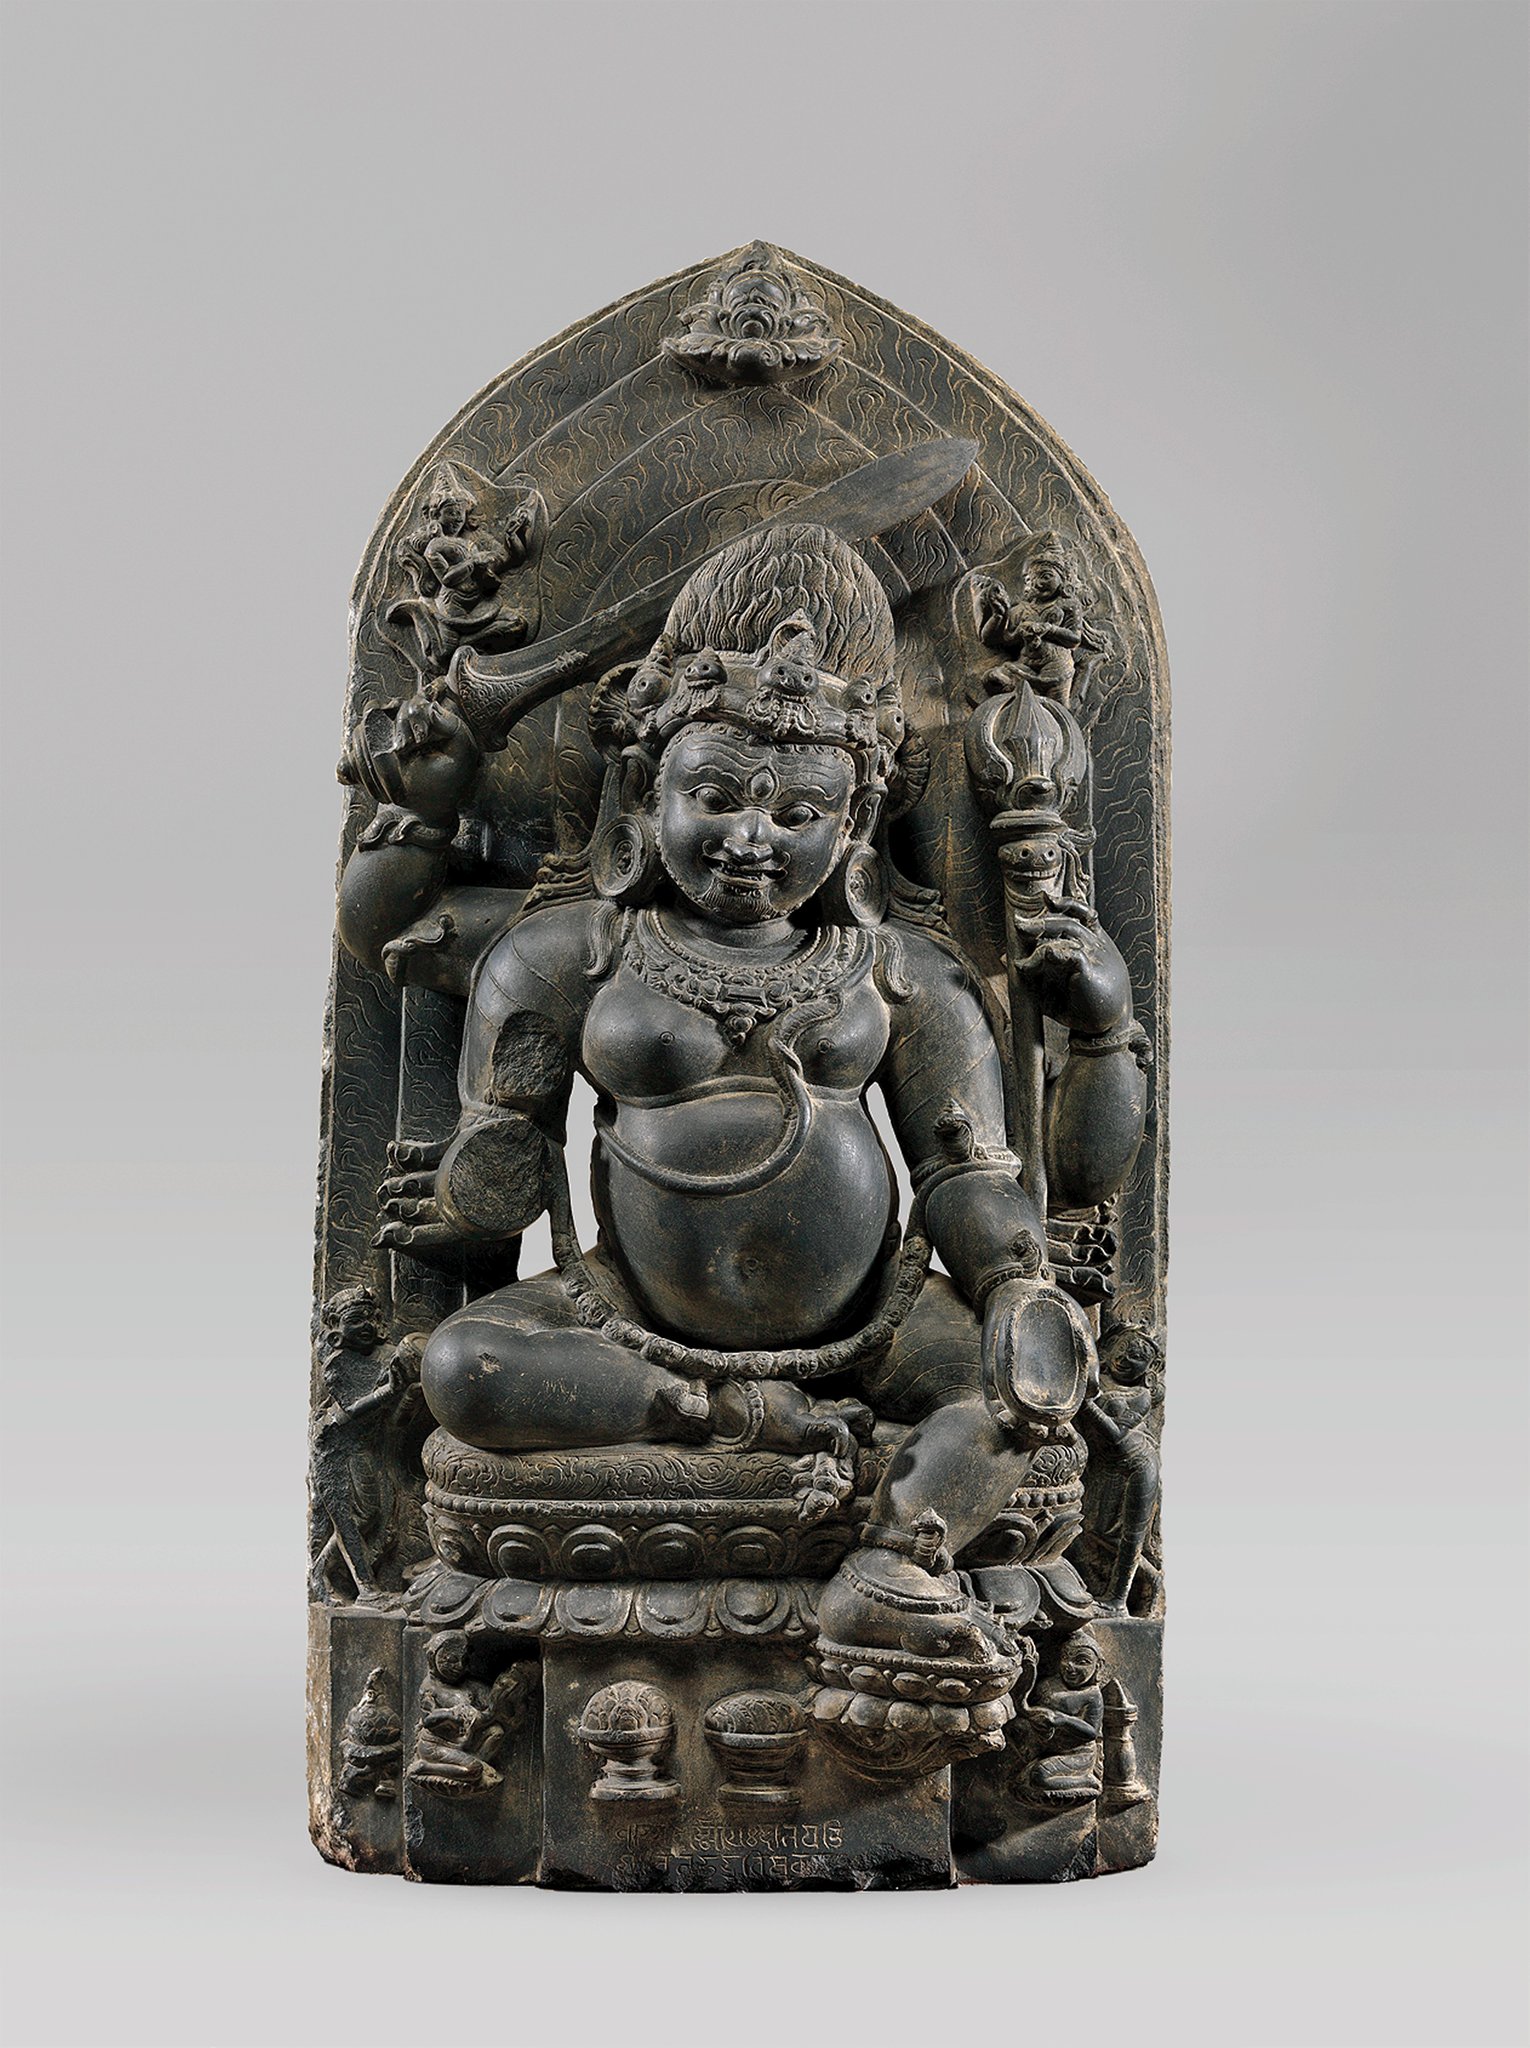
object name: stele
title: Mahakala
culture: indian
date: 1001-1200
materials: stone